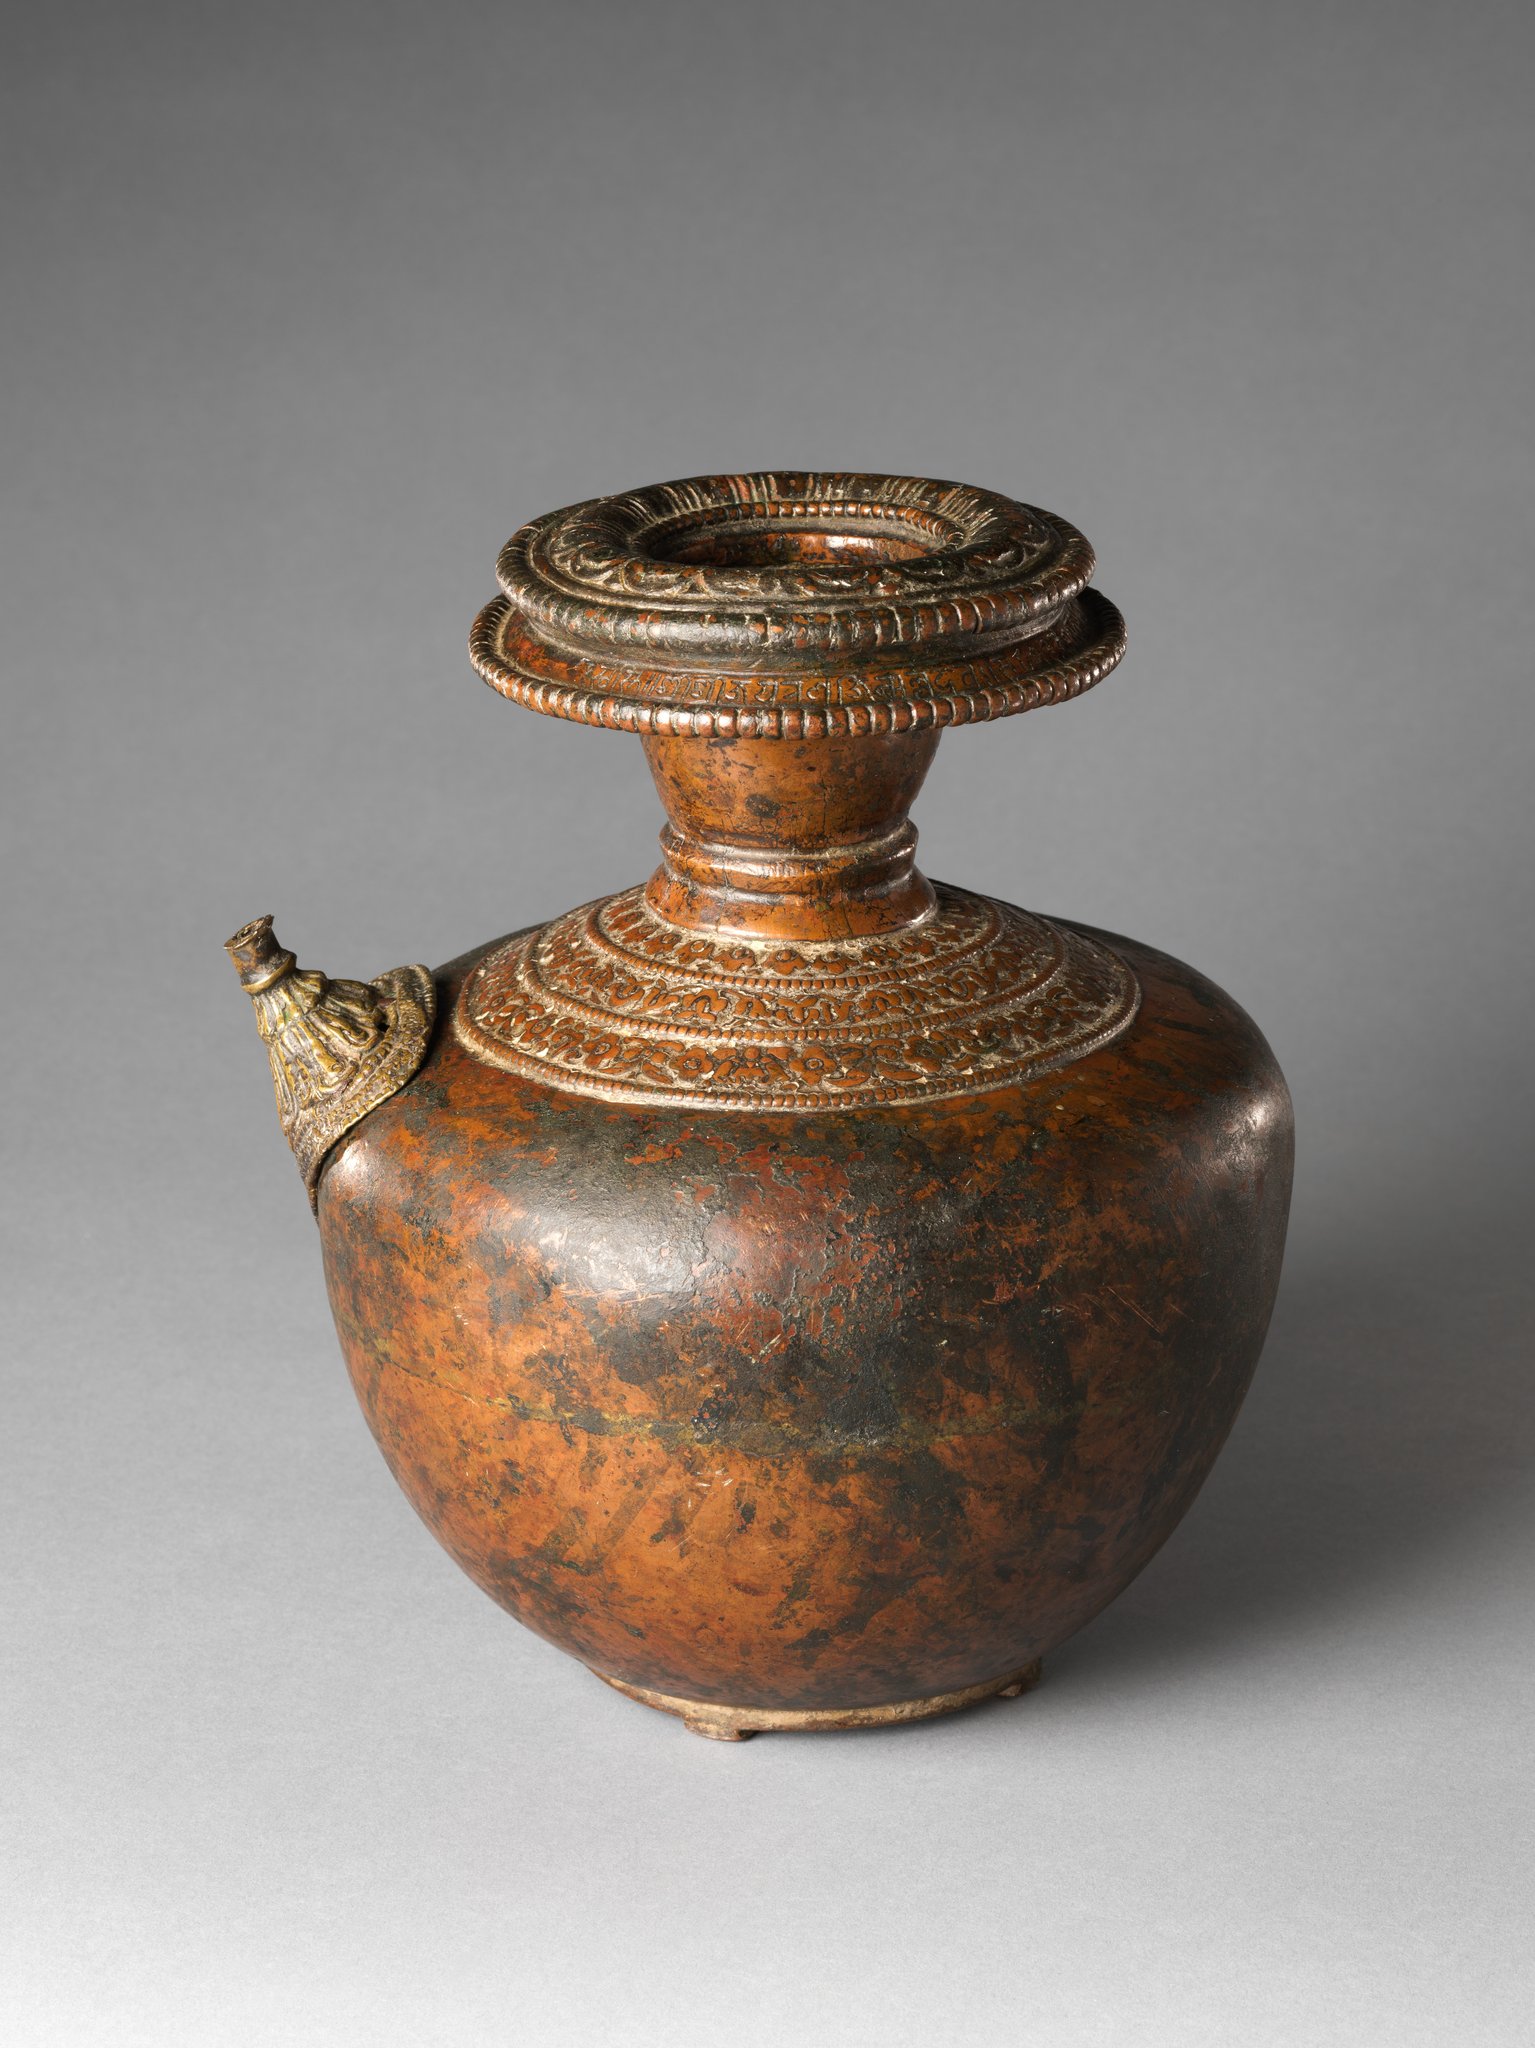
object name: ewer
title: Ritual Ewer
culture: nepali, bhaktapur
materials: copper alloy